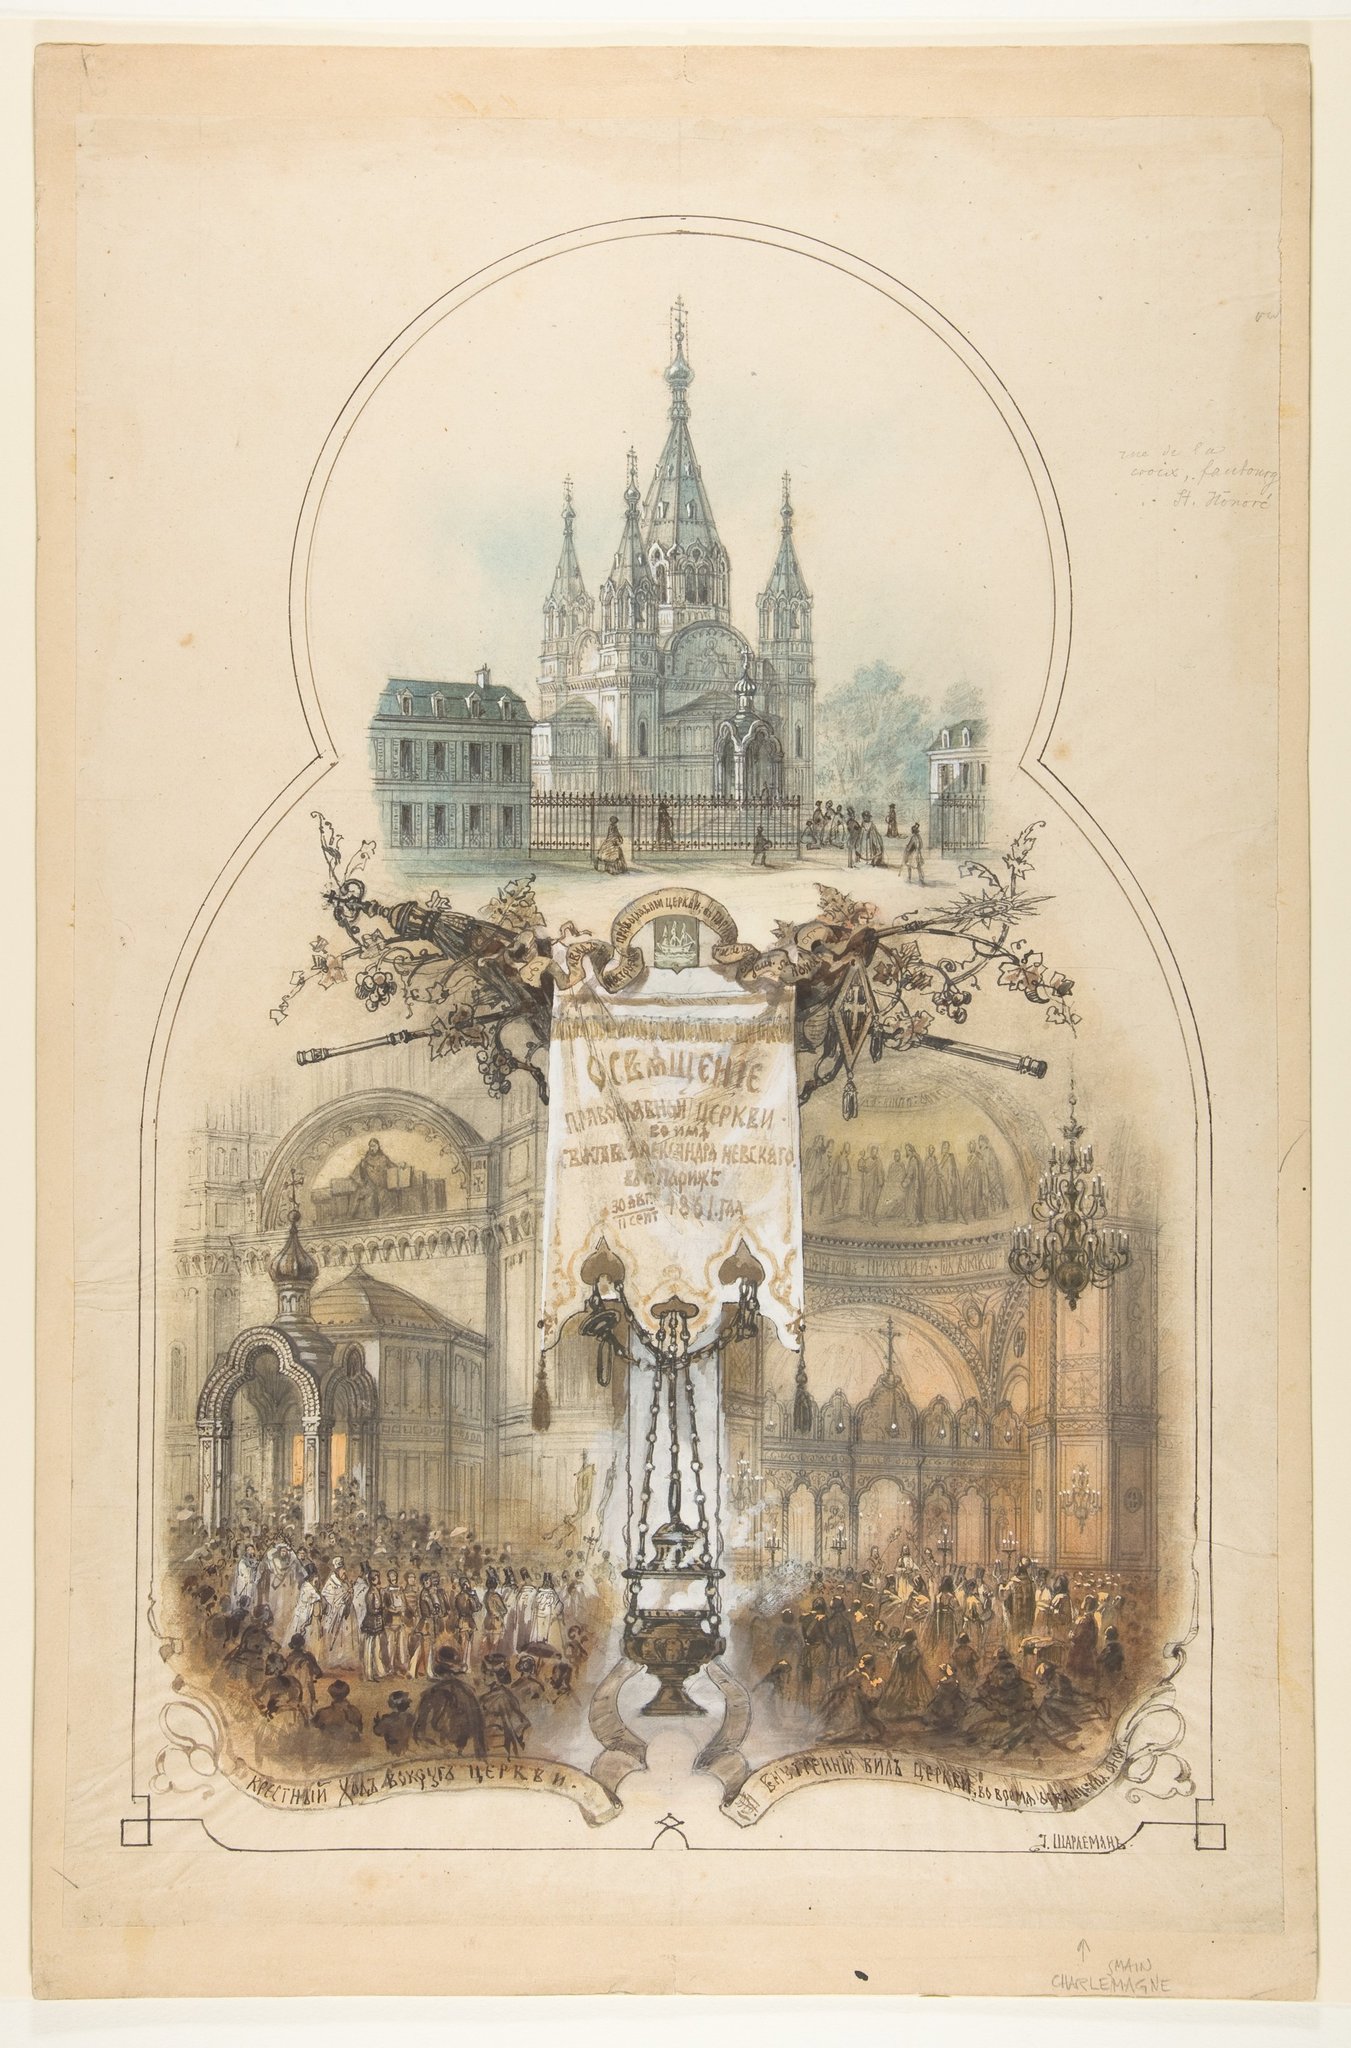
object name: drawing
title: Russian Orthodox Cathedral, Paris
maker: anonymous, french, 19th century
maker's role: artist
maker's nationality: french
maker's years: 1800-1900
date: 1801-1900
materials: gouache, graphite, ink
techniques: brush, pen, wash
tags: cathedrals,crowd,paris